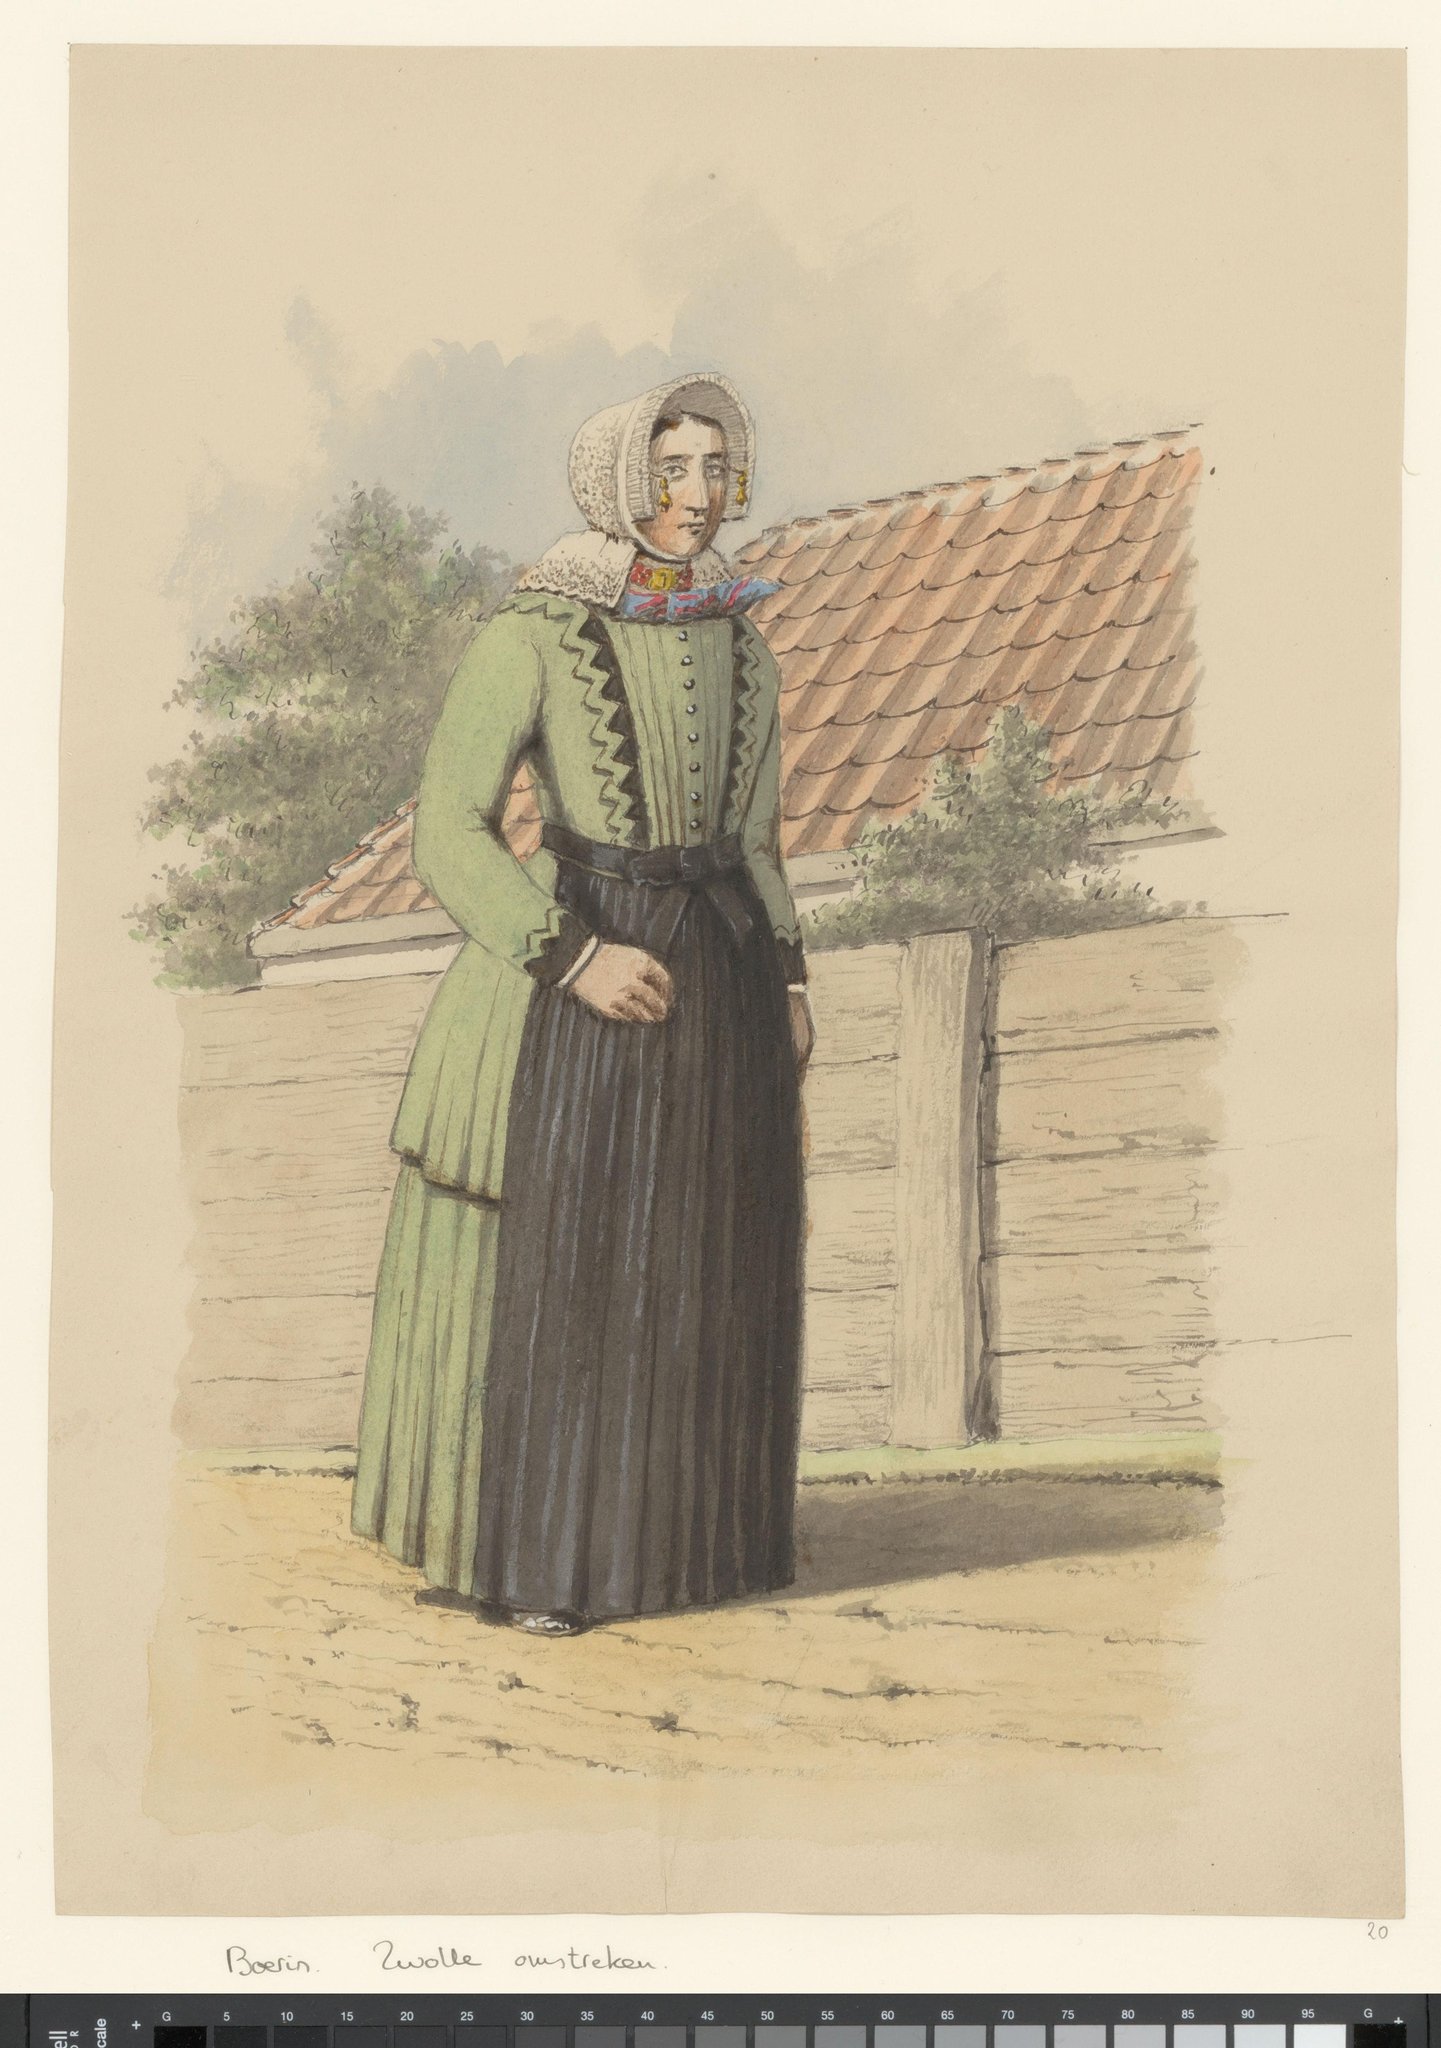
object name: drawing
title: Boerin van de omstreken van Zwolle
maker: johan martinus anthon rieke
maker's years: 1851-1899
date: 1896-1898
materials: paper, watercolor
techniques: brush, hand coloring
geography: netherlands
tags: farmers - aa - female farmer, farmer's wife, clothes, costume (+ women's clothes), folk costume, regional costume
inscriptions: collector's mark: Lugt 1641, collector's mark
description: Boerin van de omstreken van Zwolle. Tekening vervaardigd voor de tentoonstelling over Nederlandse klederdrachten gehouden in het Stedelijk Museum te Amsterdam in september 1898. Onderwerpsrubrieken binnen de Atlas Zeden en Gewoonten: De Kleeding, Volkskleederdracht, Overijssel.